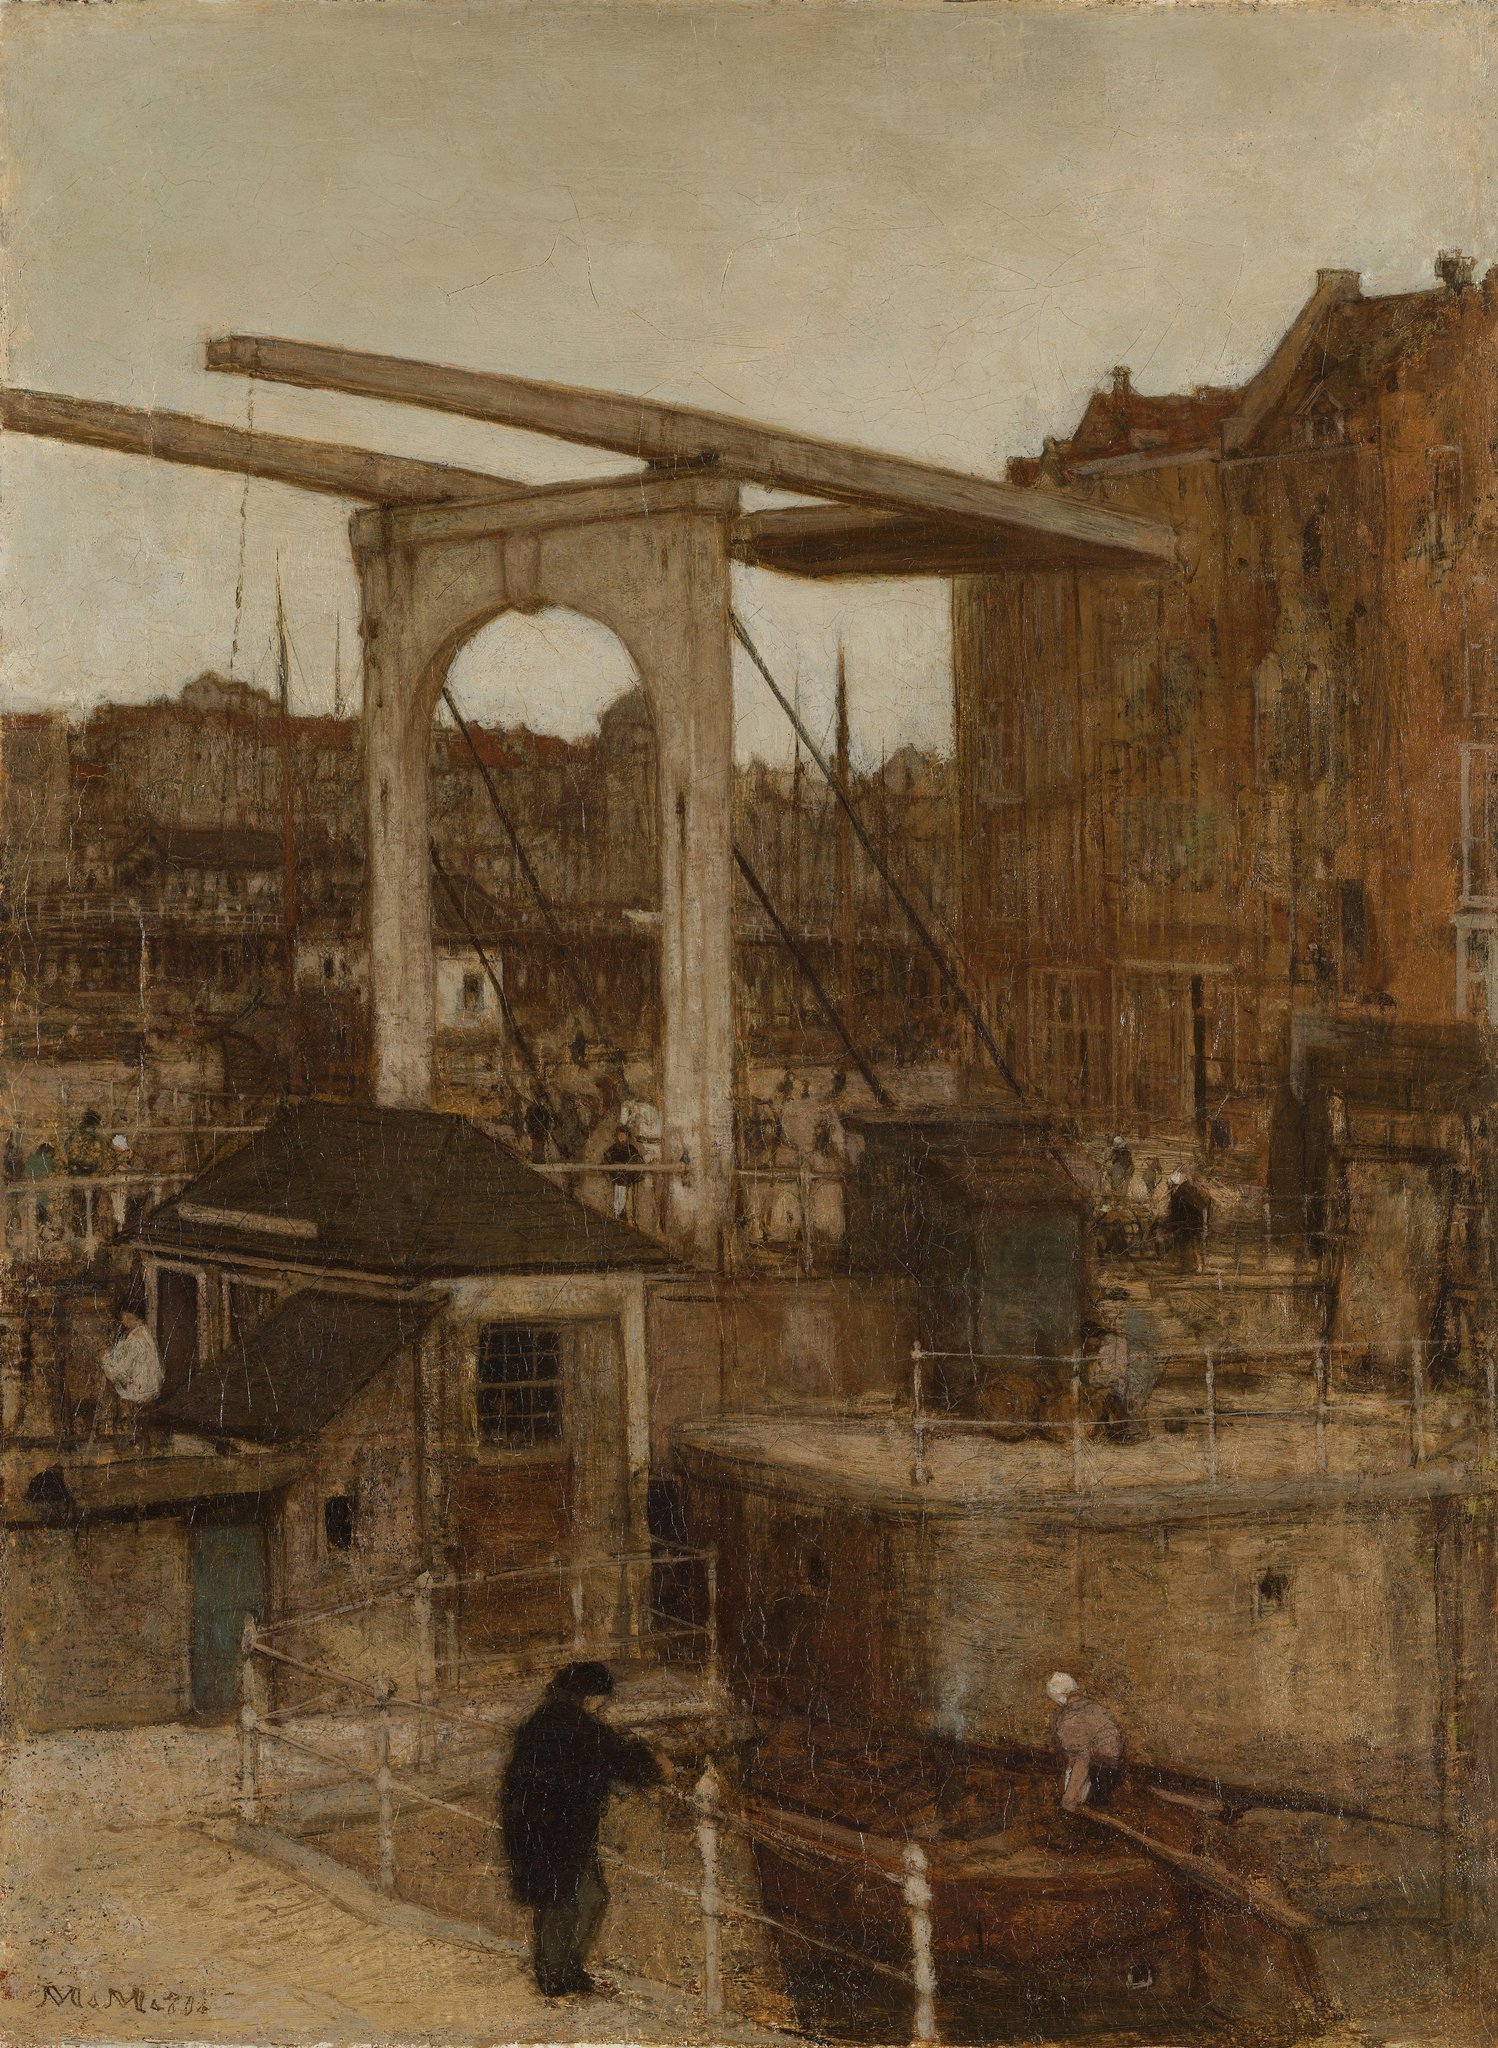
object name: painting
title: The Nieuwe Haarlemse Sluis on the Singel, known as ‘Souvenir d’Amsterdam’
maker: matthijs maris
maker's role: draughtsman, painter, print maker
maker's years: 1839-1917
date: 1871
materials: canvas, oil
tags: sluice, weir, city-view in general; 'veduta'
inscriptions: signature and date: ‘M.M.71.’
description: When Jacob returned to the Netherlands, Matthijs had to support himself in Paris. His financial worries explain why he reused an already painted canvas for this work. Beneath this city view is a landscape with a ferry; probably an oil sketch Jacob had left behind. Parts of this underlying composition are still visible. The bright green brushstrokes in the brown foreground at the right are from the overgrown bank underneath.